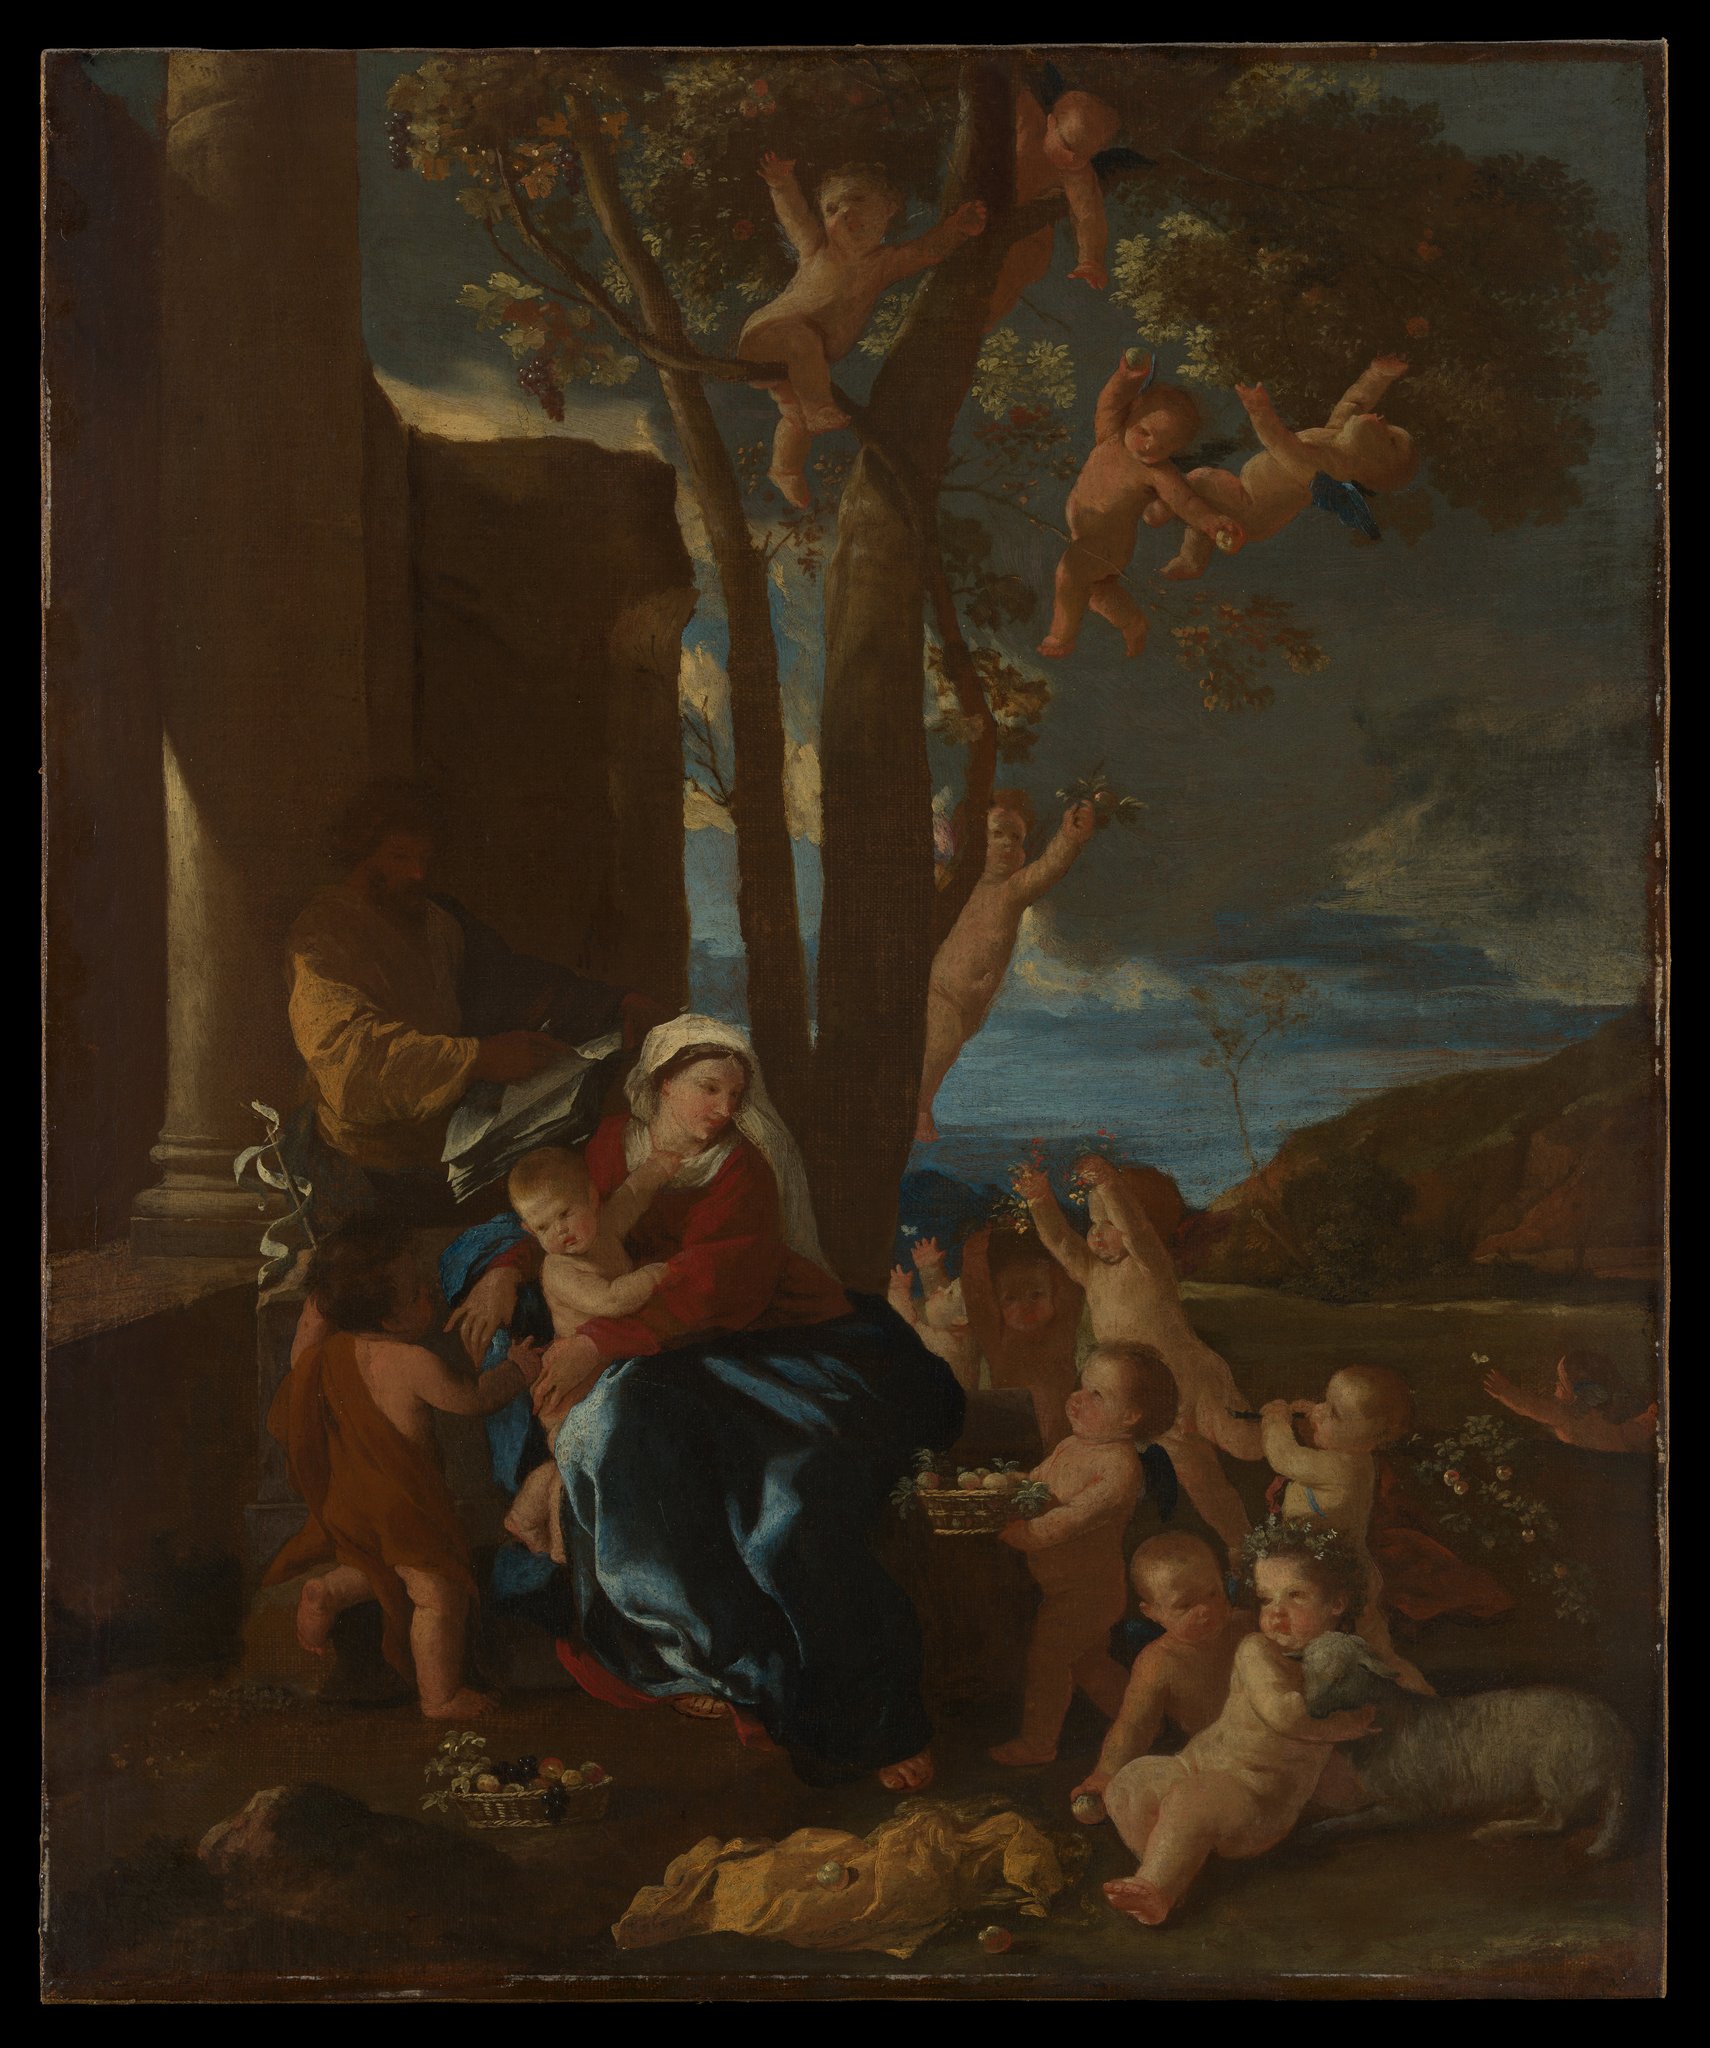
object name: painting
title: The Holy Family with Saint John the Baptist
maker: nicolas poussin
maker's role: artist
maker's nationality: french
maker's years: 1594-1665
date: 1627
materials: canvas, oil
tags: infants,holy family,madonna and child,saint john the baptist